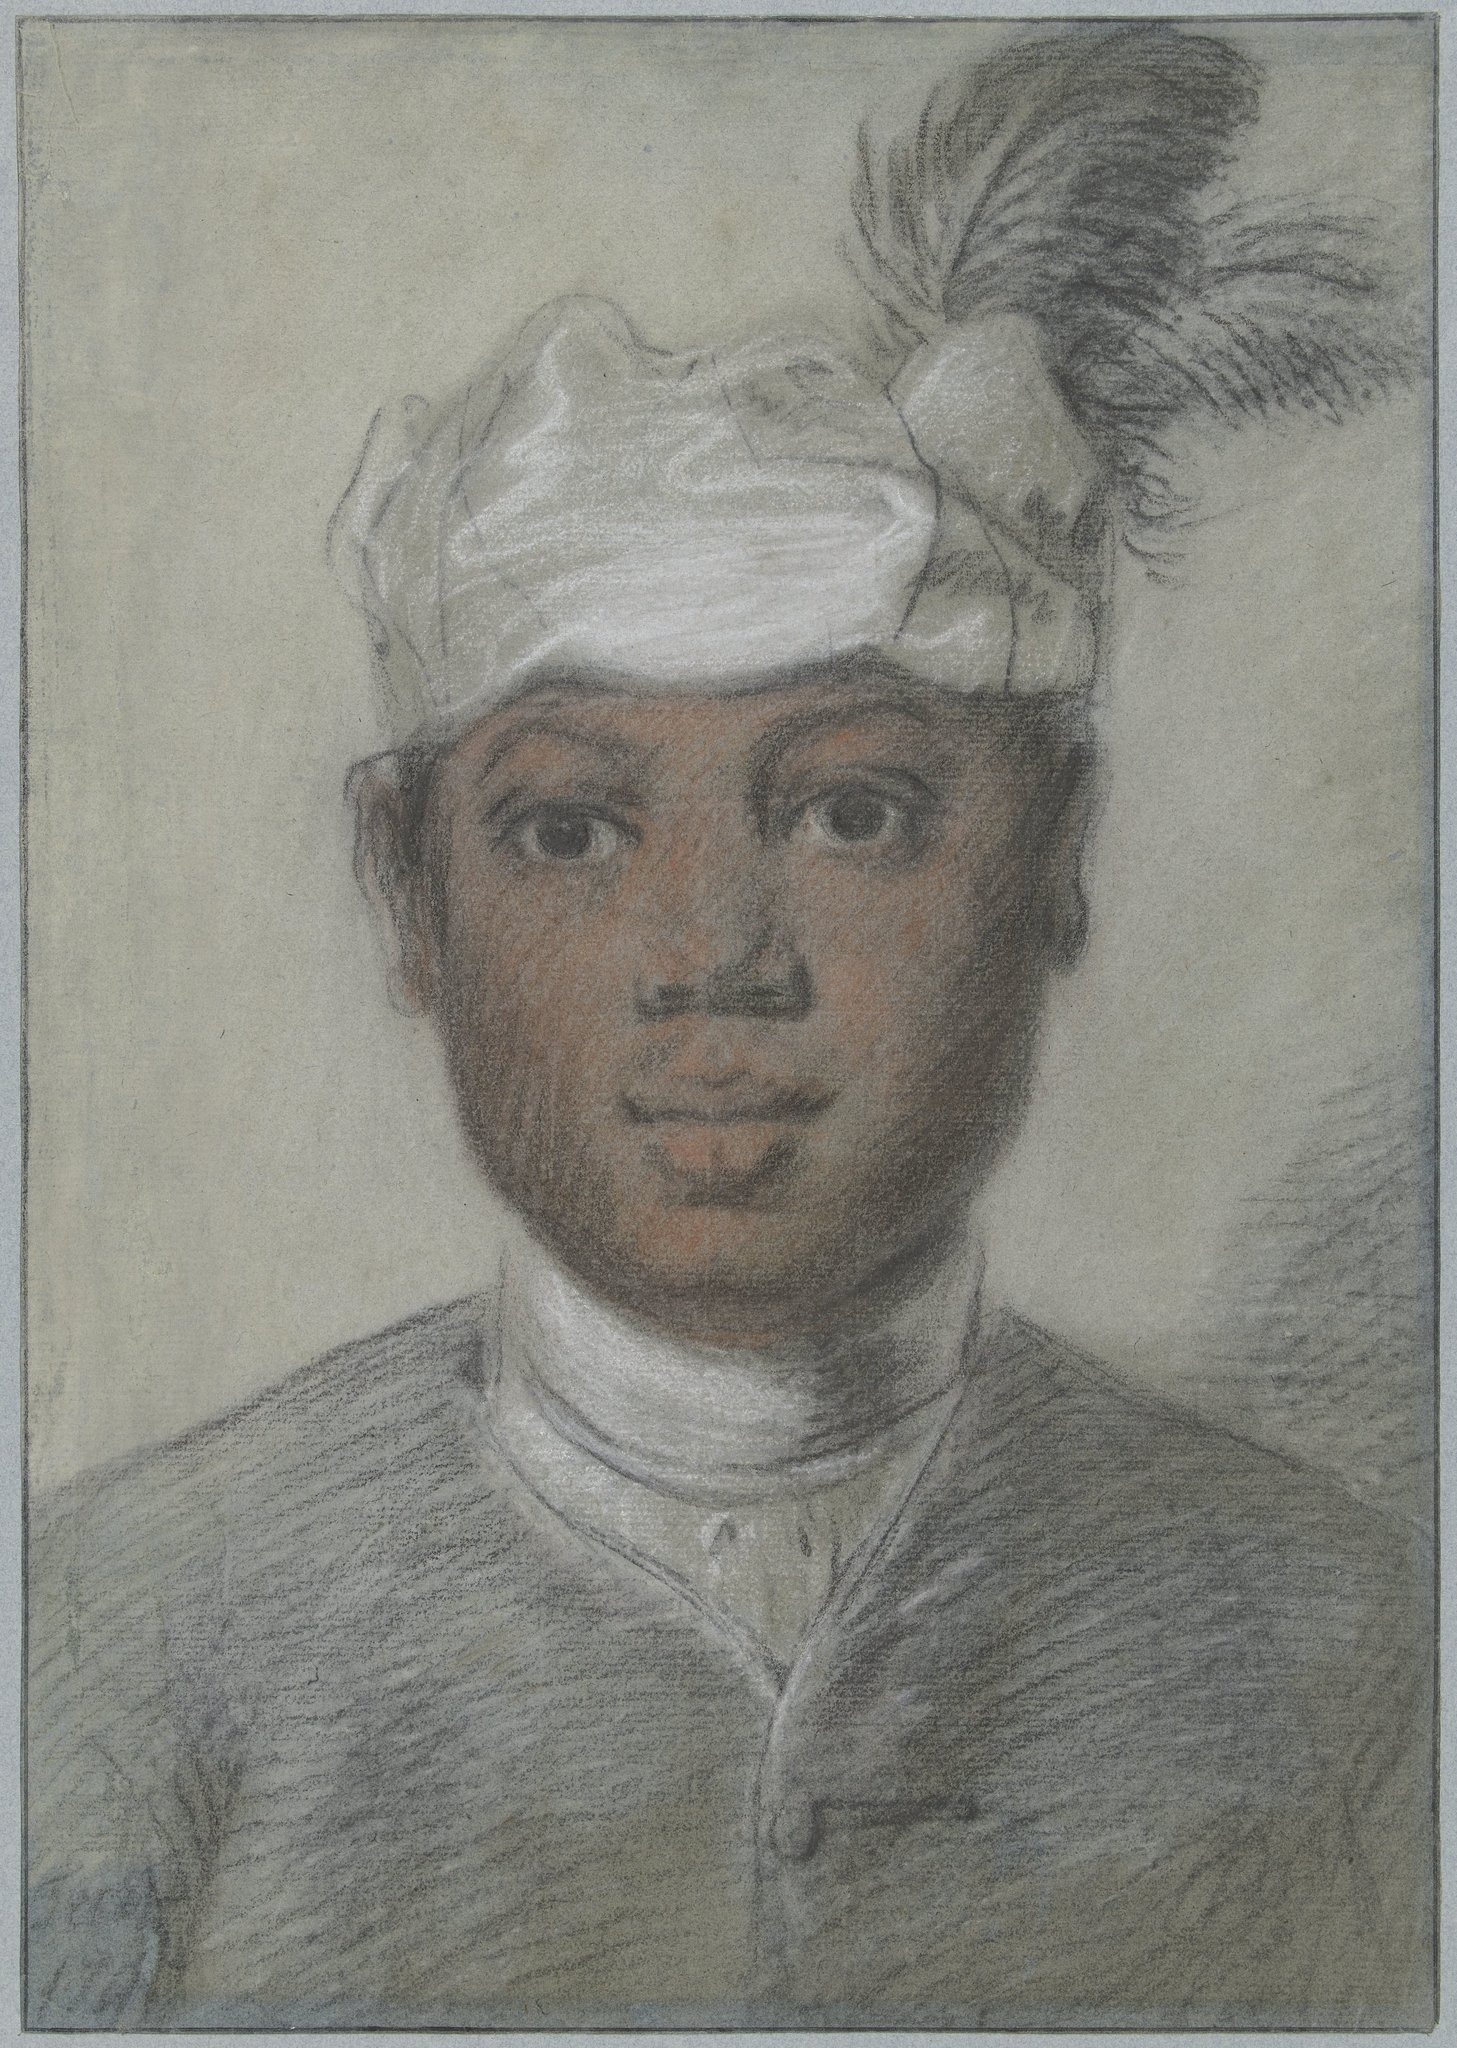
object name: drawing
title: Hoofd van een zwarte jongeman met tulband met veren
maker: cornelis troost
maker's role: draughtsman, painter, print maker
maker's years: 1696-1750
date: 1747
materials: paper, pastel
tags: anonymous historical person portrayed alone, africans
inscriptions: date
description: Niemeijer, nr. 180T : Jong negerknechtje